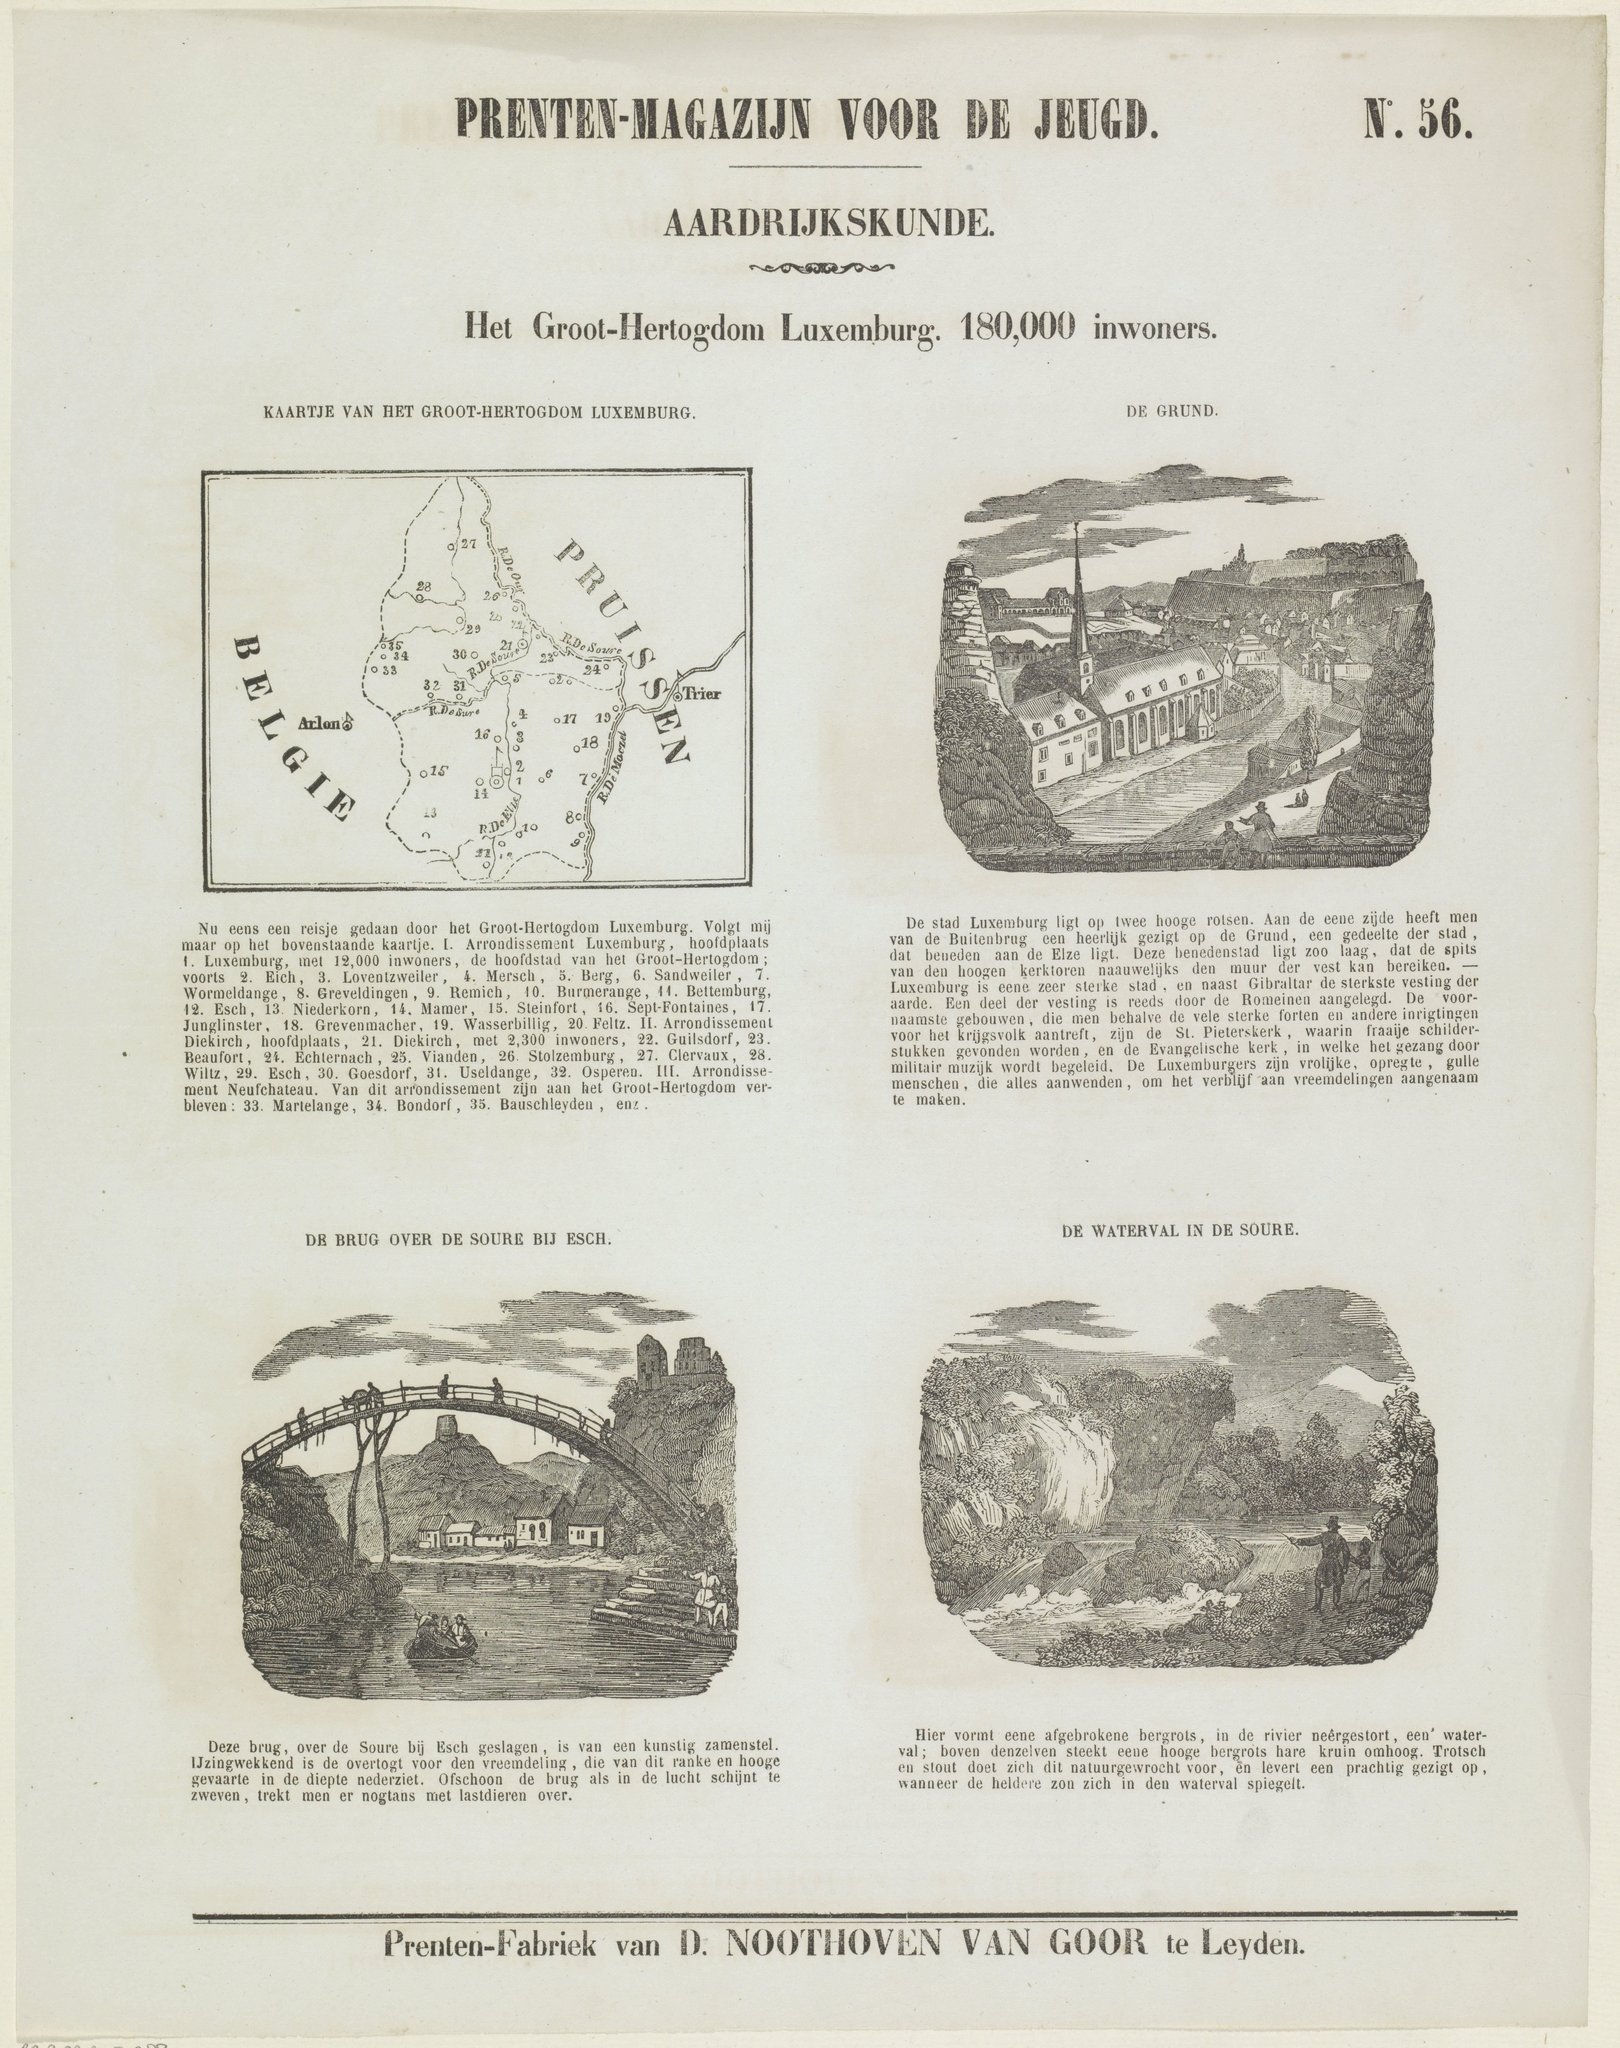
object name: popular print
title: Aardrijkskunde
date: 1850-1881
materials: paper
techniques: letterpress printing, engraving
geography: netherlands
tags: maps, atlases, bridge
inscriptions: collector's mark: Lugt 2760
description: Blad met 4 voorstellingen over het groot-hertogdom Luxemburg met een kaart en belangrijke plaatsen: Grund, de brug over de Sûre en de waterval in de Sûre. Boven elke voorstelling een titel en onder elke voorstelling een onderschrift. Genummerd rechtsboven: No. 56.